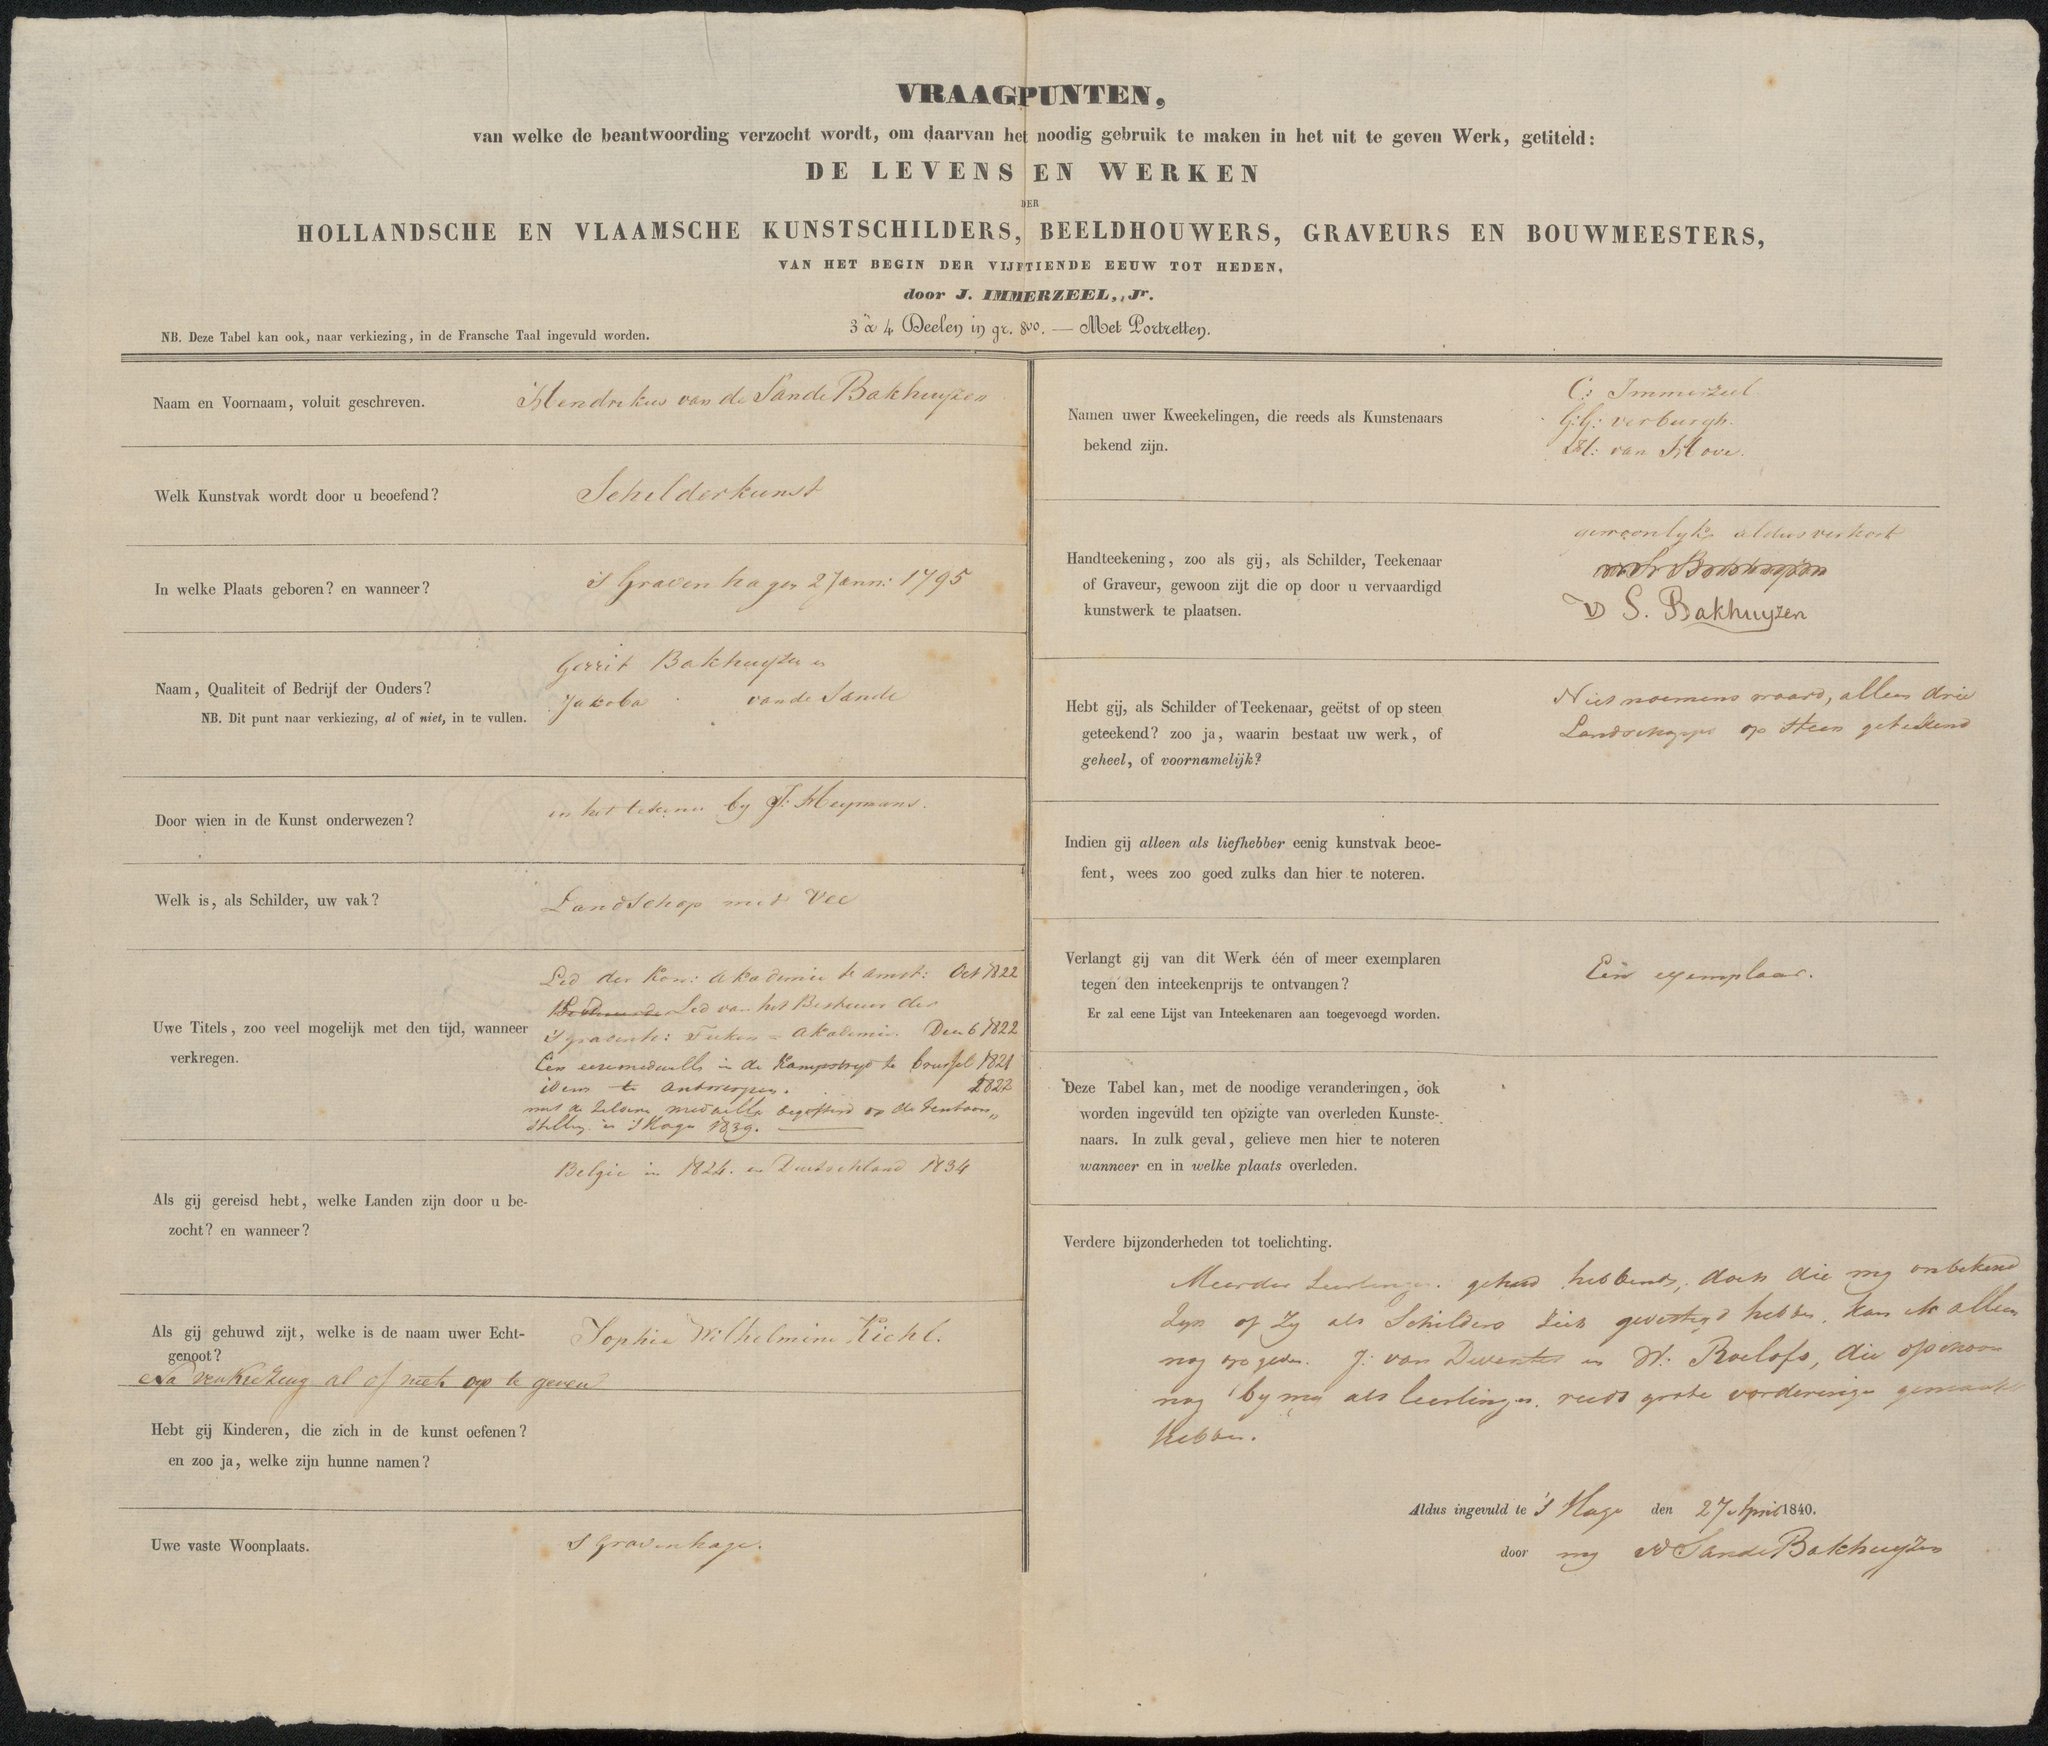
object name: manuscript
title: Enquêteformulier ingevuld door Hendrikus van de Sande Bakhuyzen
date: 1840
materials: ink, paper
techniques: pen, printing, writing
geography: the hague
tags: the hague, painter, print maker, draughtsman, hendrikus van de sande bakhuyzen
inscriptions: watermark, inscription: ‘Vraagpunten,/ van welke de beantwoording verzocht wordt, om daarvan het noodig gebruik te maken in het uit te geven Werk, getiteld: De levens en werken/ der Hollandsche en Vlaamsche kunstschilders, beeldhouwers,/ graveurs en bouwmeesters, van het begin der vijftiende eeuw tot heden/ door J. Immerzeel, Jr.’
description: Opgenomen in: Immerzeel, J. Jr., De levens en werken der Hollandsche en Vlaamsche kunstschilders, beeldhouwers, graveurs en bouwmeesters, van het begin der vijftiende eeuw tot heden, Amsterdam: J.C. van Kesteren, 1842-1843.